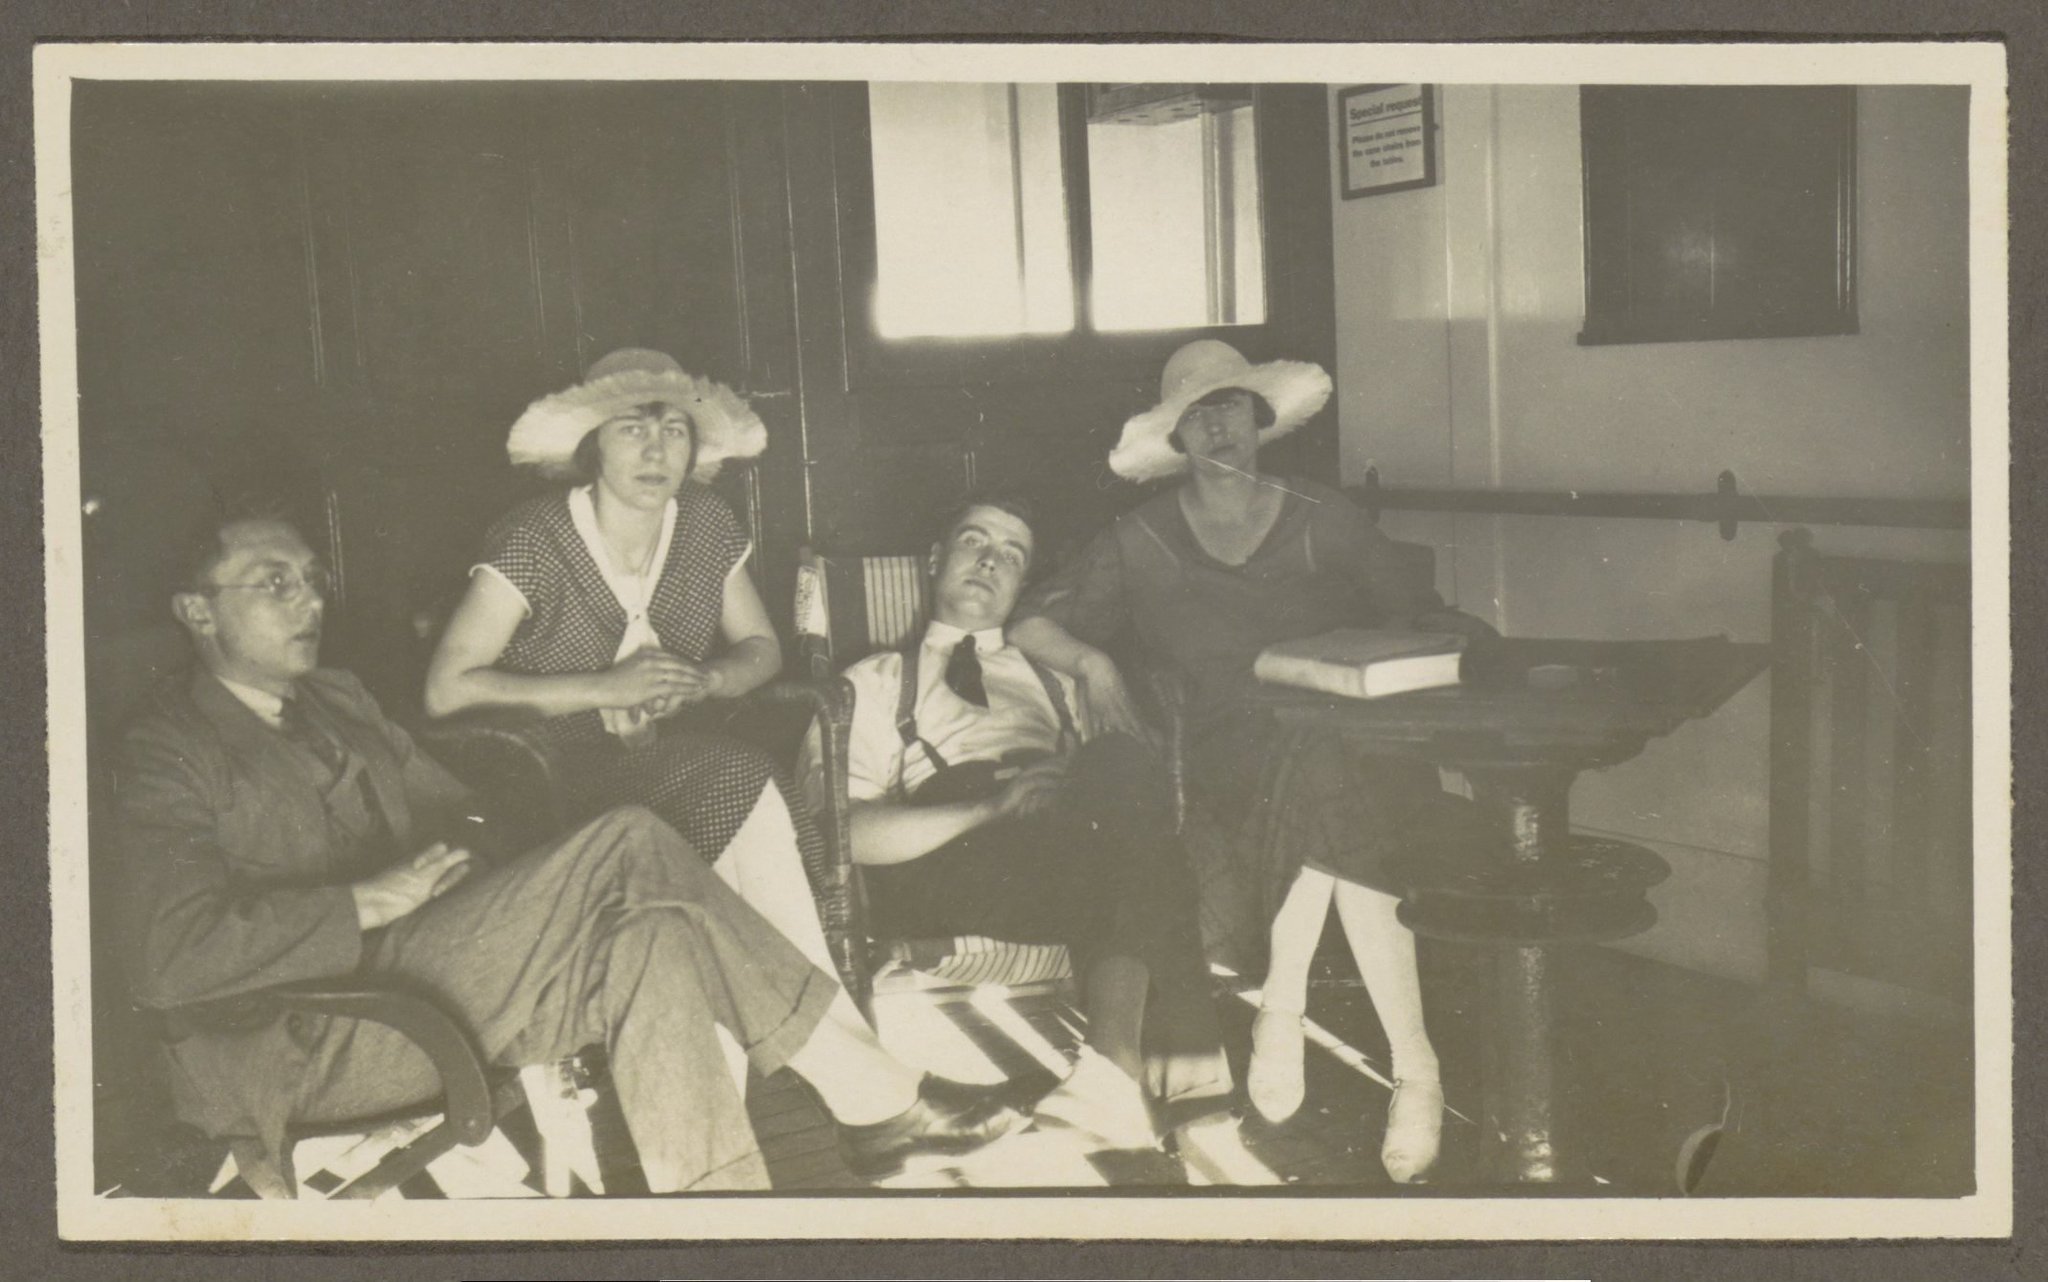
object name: photograph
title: Twee mannen en twee vrouwen aan boord van een schip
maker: Anonymous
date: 1920-1930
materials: photographic support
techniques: gelatin silver print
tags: parts of ship's interior (with name)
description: Onderdeel van familiealbum Nederlands-Indië.